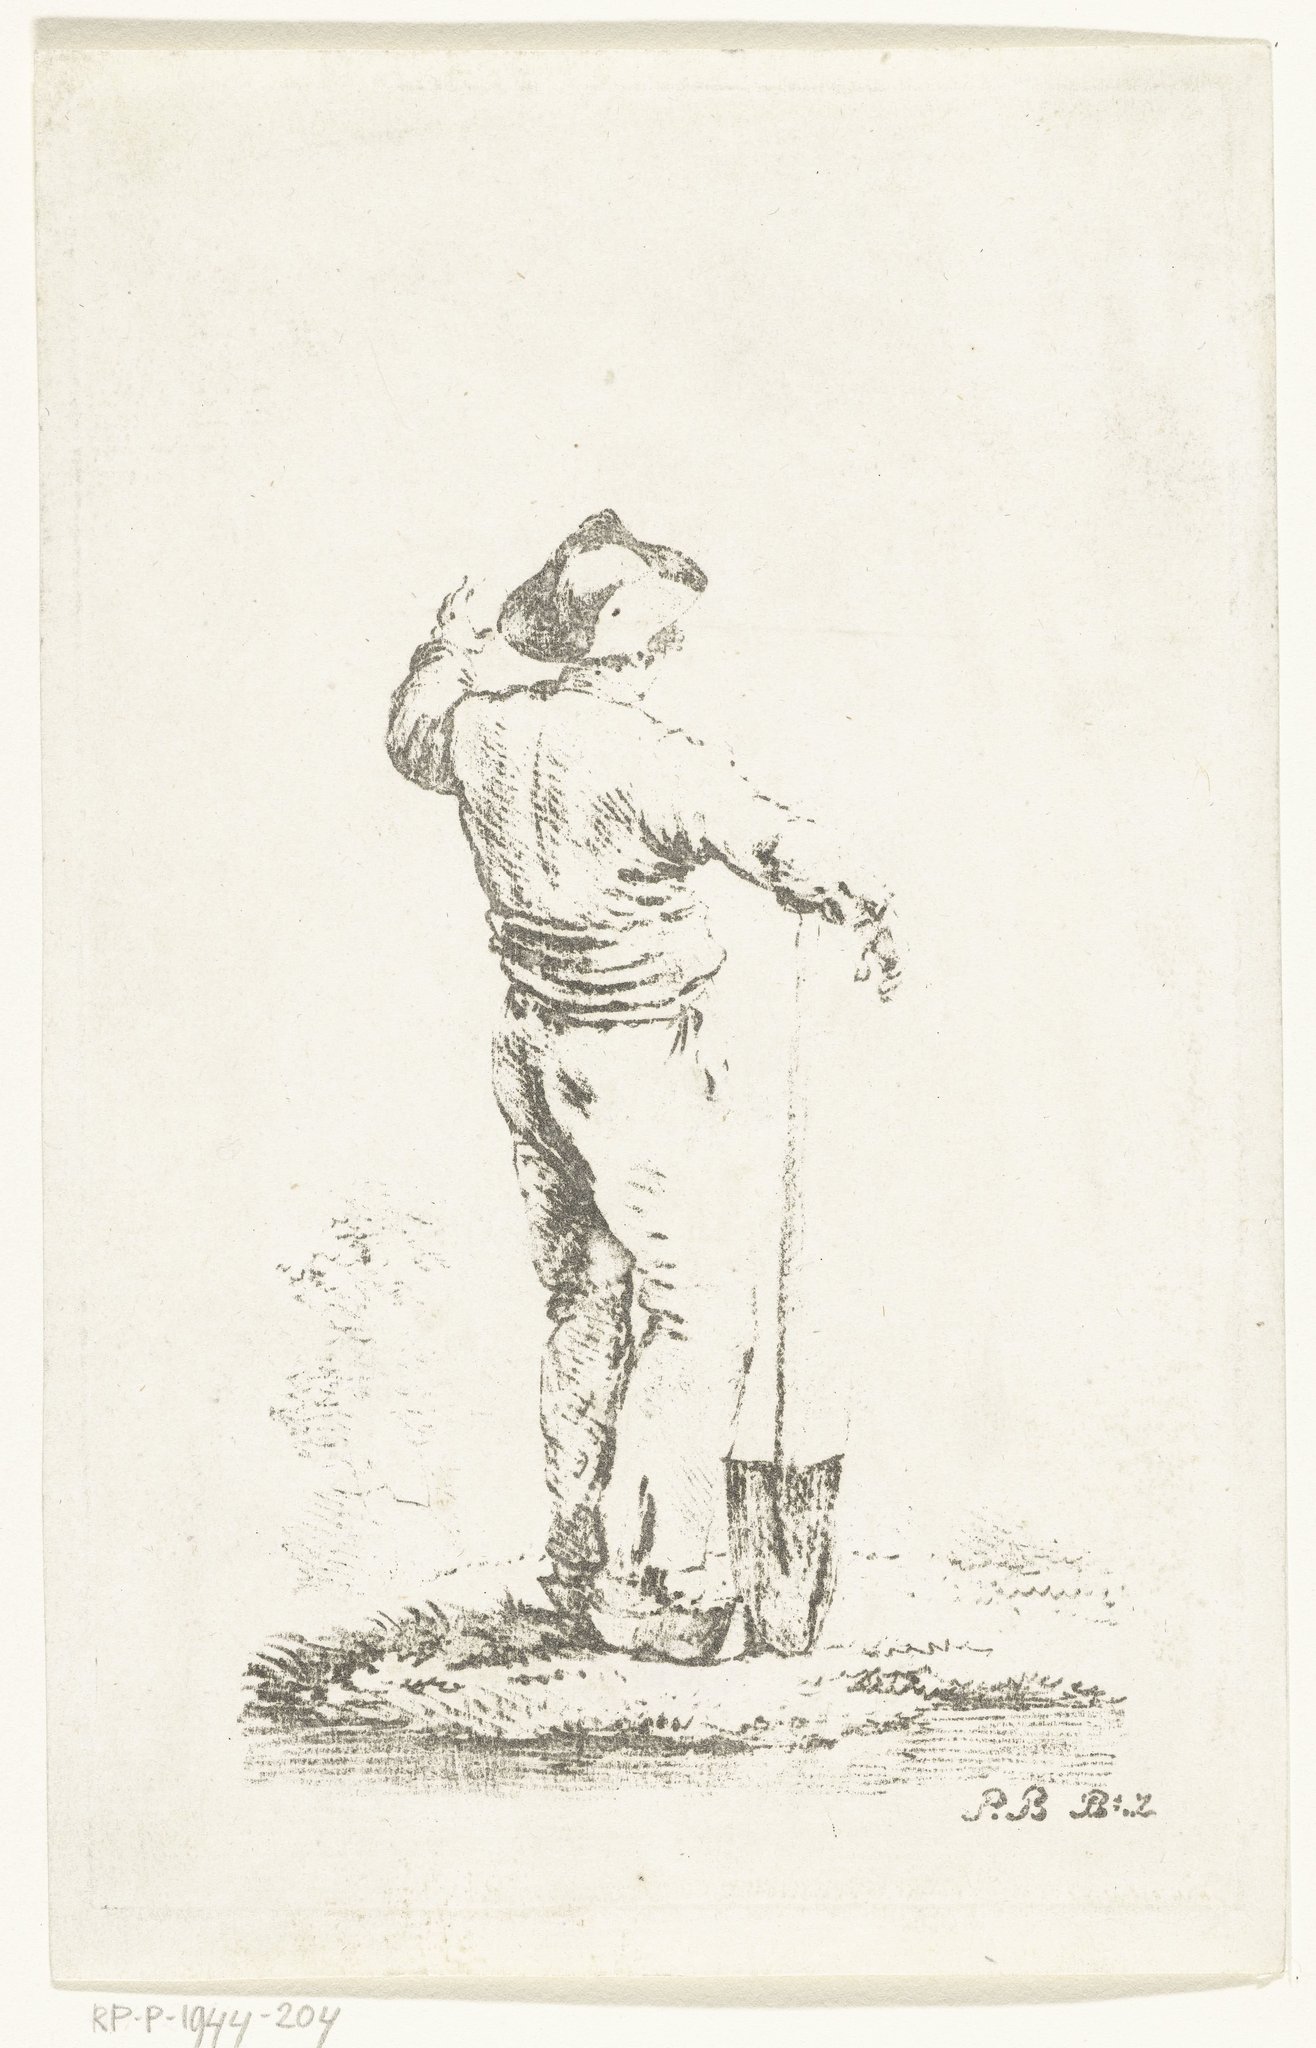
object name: print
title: Man leunt op schop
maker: pieter barbiers (iv)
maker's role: painter, print maker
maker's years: 1798-1848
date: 1808-1848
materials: paper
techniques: soft ground etching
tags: agricultural implements: spade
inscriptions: collector's mark: Lugt 2228